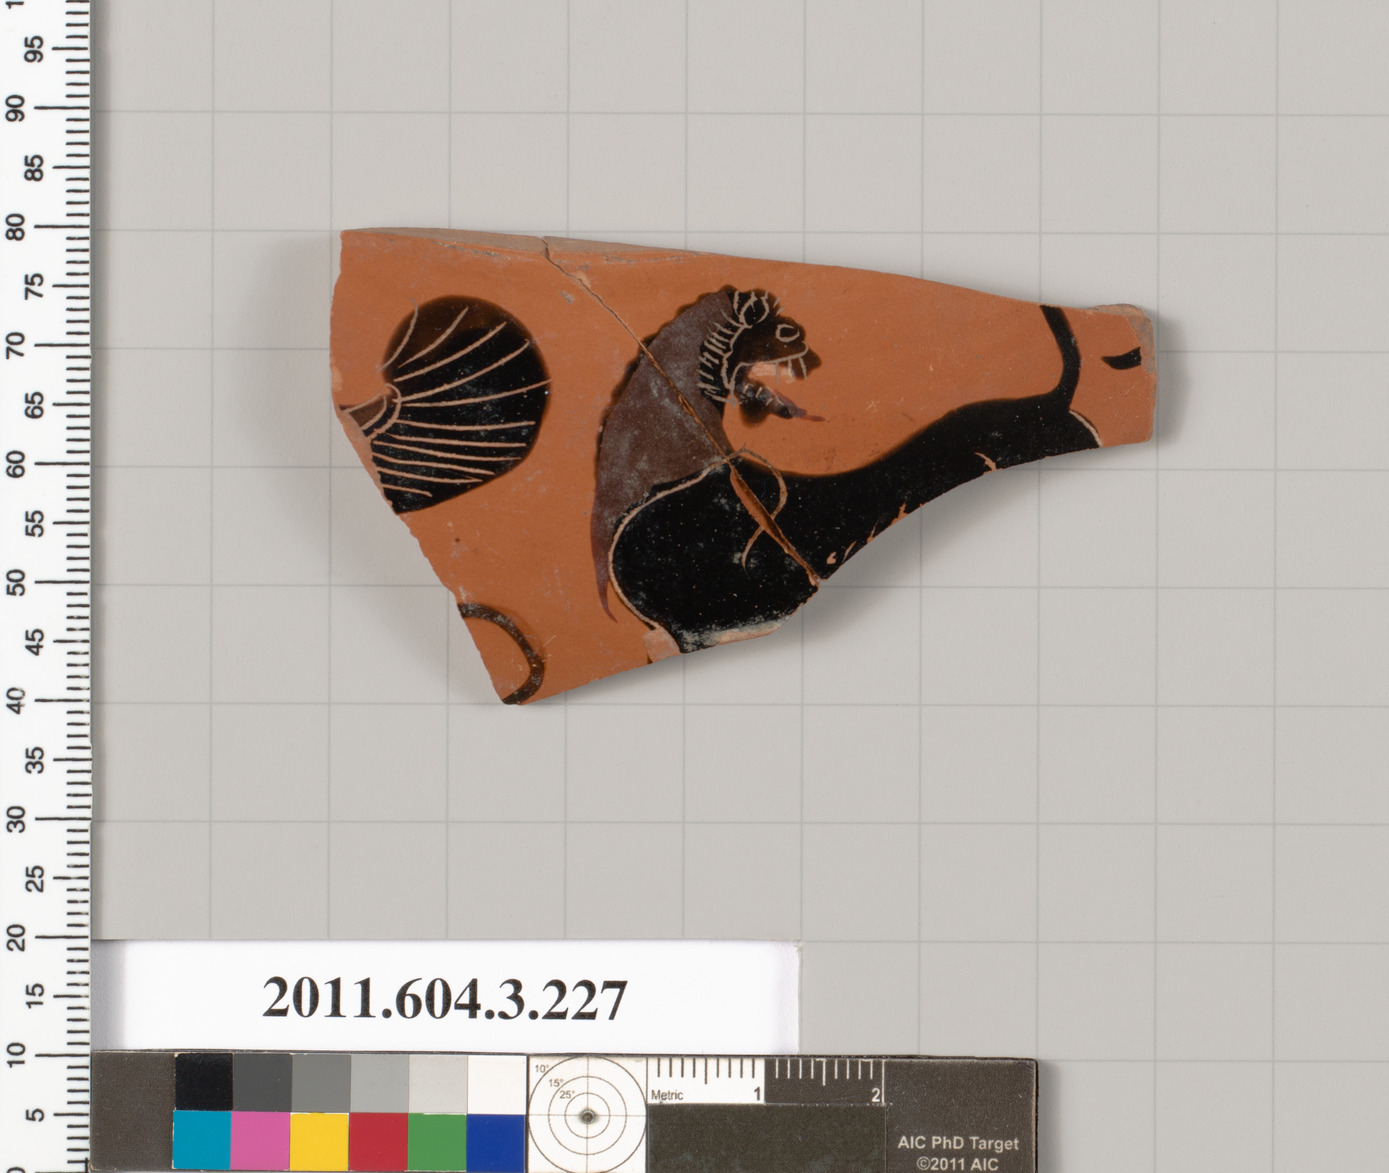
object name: neck amphora fragment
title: Terracotta fragment of a neck-amphora of Nicosthenic shape (jar)?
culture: greek, attic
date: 530-520 BCE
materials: terracotta